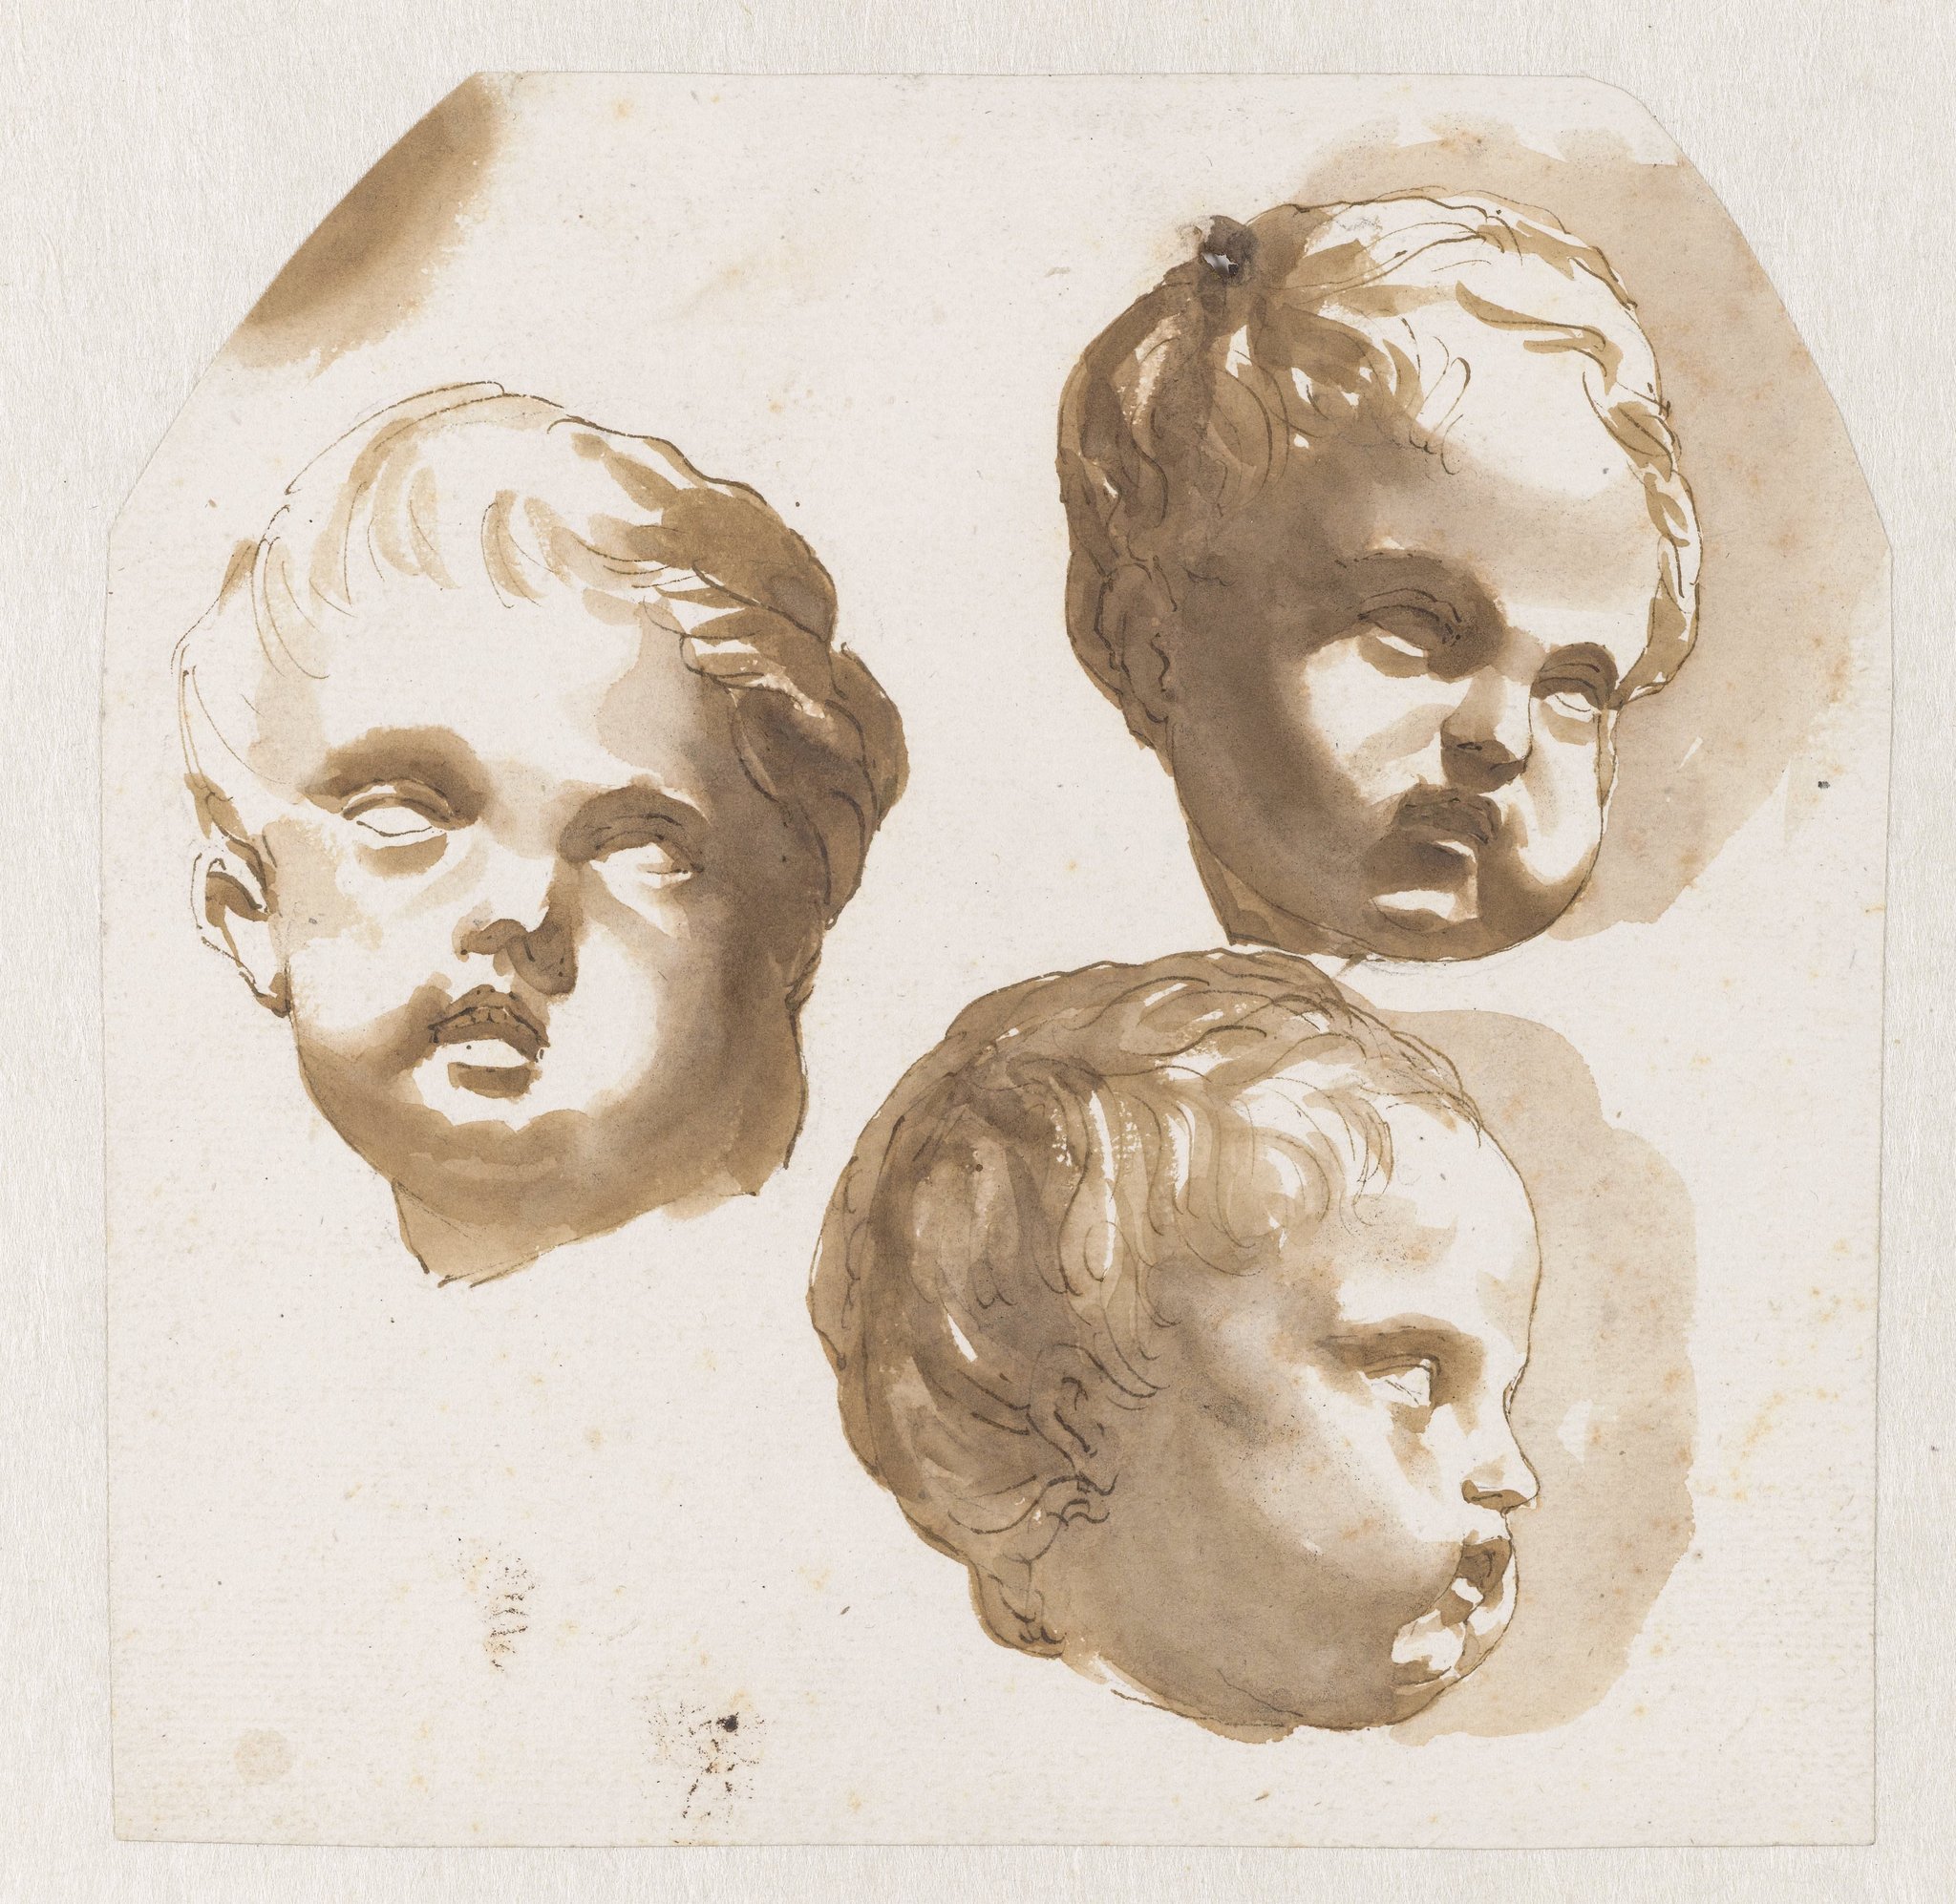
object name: drawing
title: Kinderhoofdje van drie kanten gezien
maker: jan de bisschop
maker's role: draughtsman, print maker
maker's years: 1628-1671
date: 1648-1671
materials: chalk, graphite, ink, paper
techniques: brush, pen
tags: head (human), piece of sculpture, reproduction of a piece of sculpture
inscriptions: date: ‘Febr. 1668’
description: Drie kopieën naar een gebeeldhouwd kinderkopje.